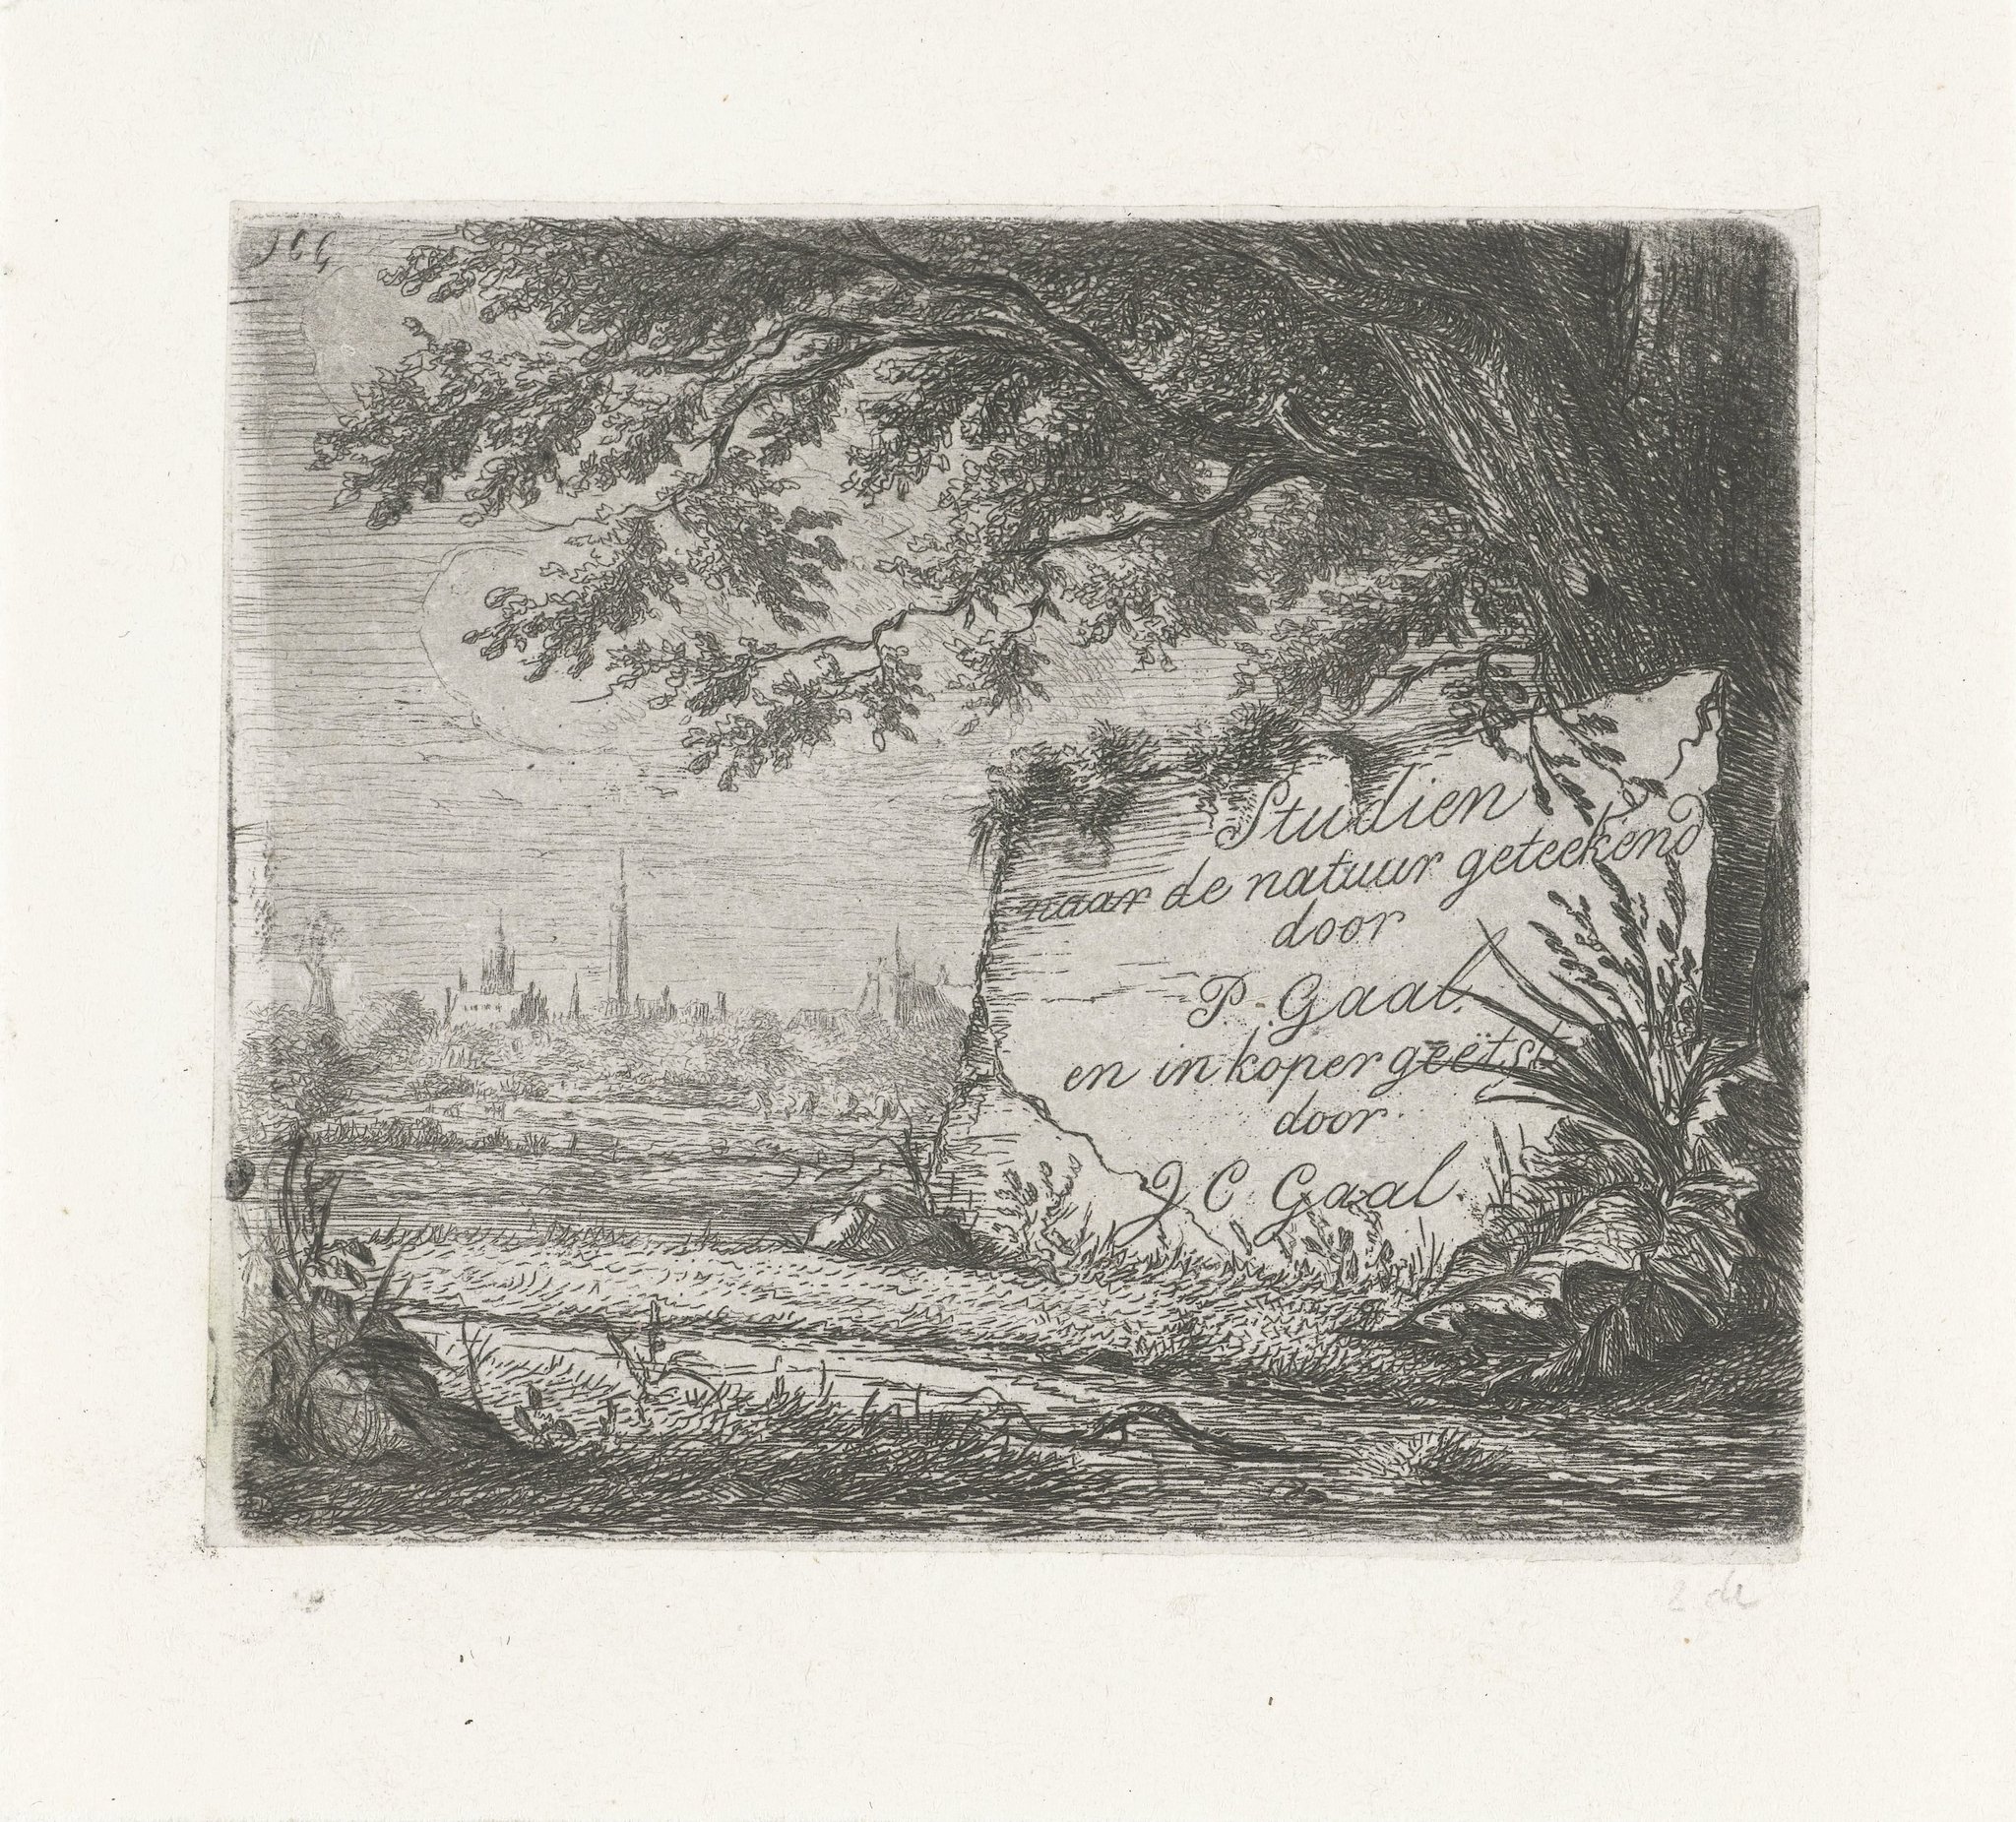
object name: print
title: Titelprent voor: Studien naar de natuur geteekend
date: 1851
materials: paper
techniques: etching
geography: the hague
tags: landscapes in the temperate zone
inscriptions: collector's mark: Lugt 2228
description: Landschap met in het verschiet een dorp. Onder een boom een steen met de titel.